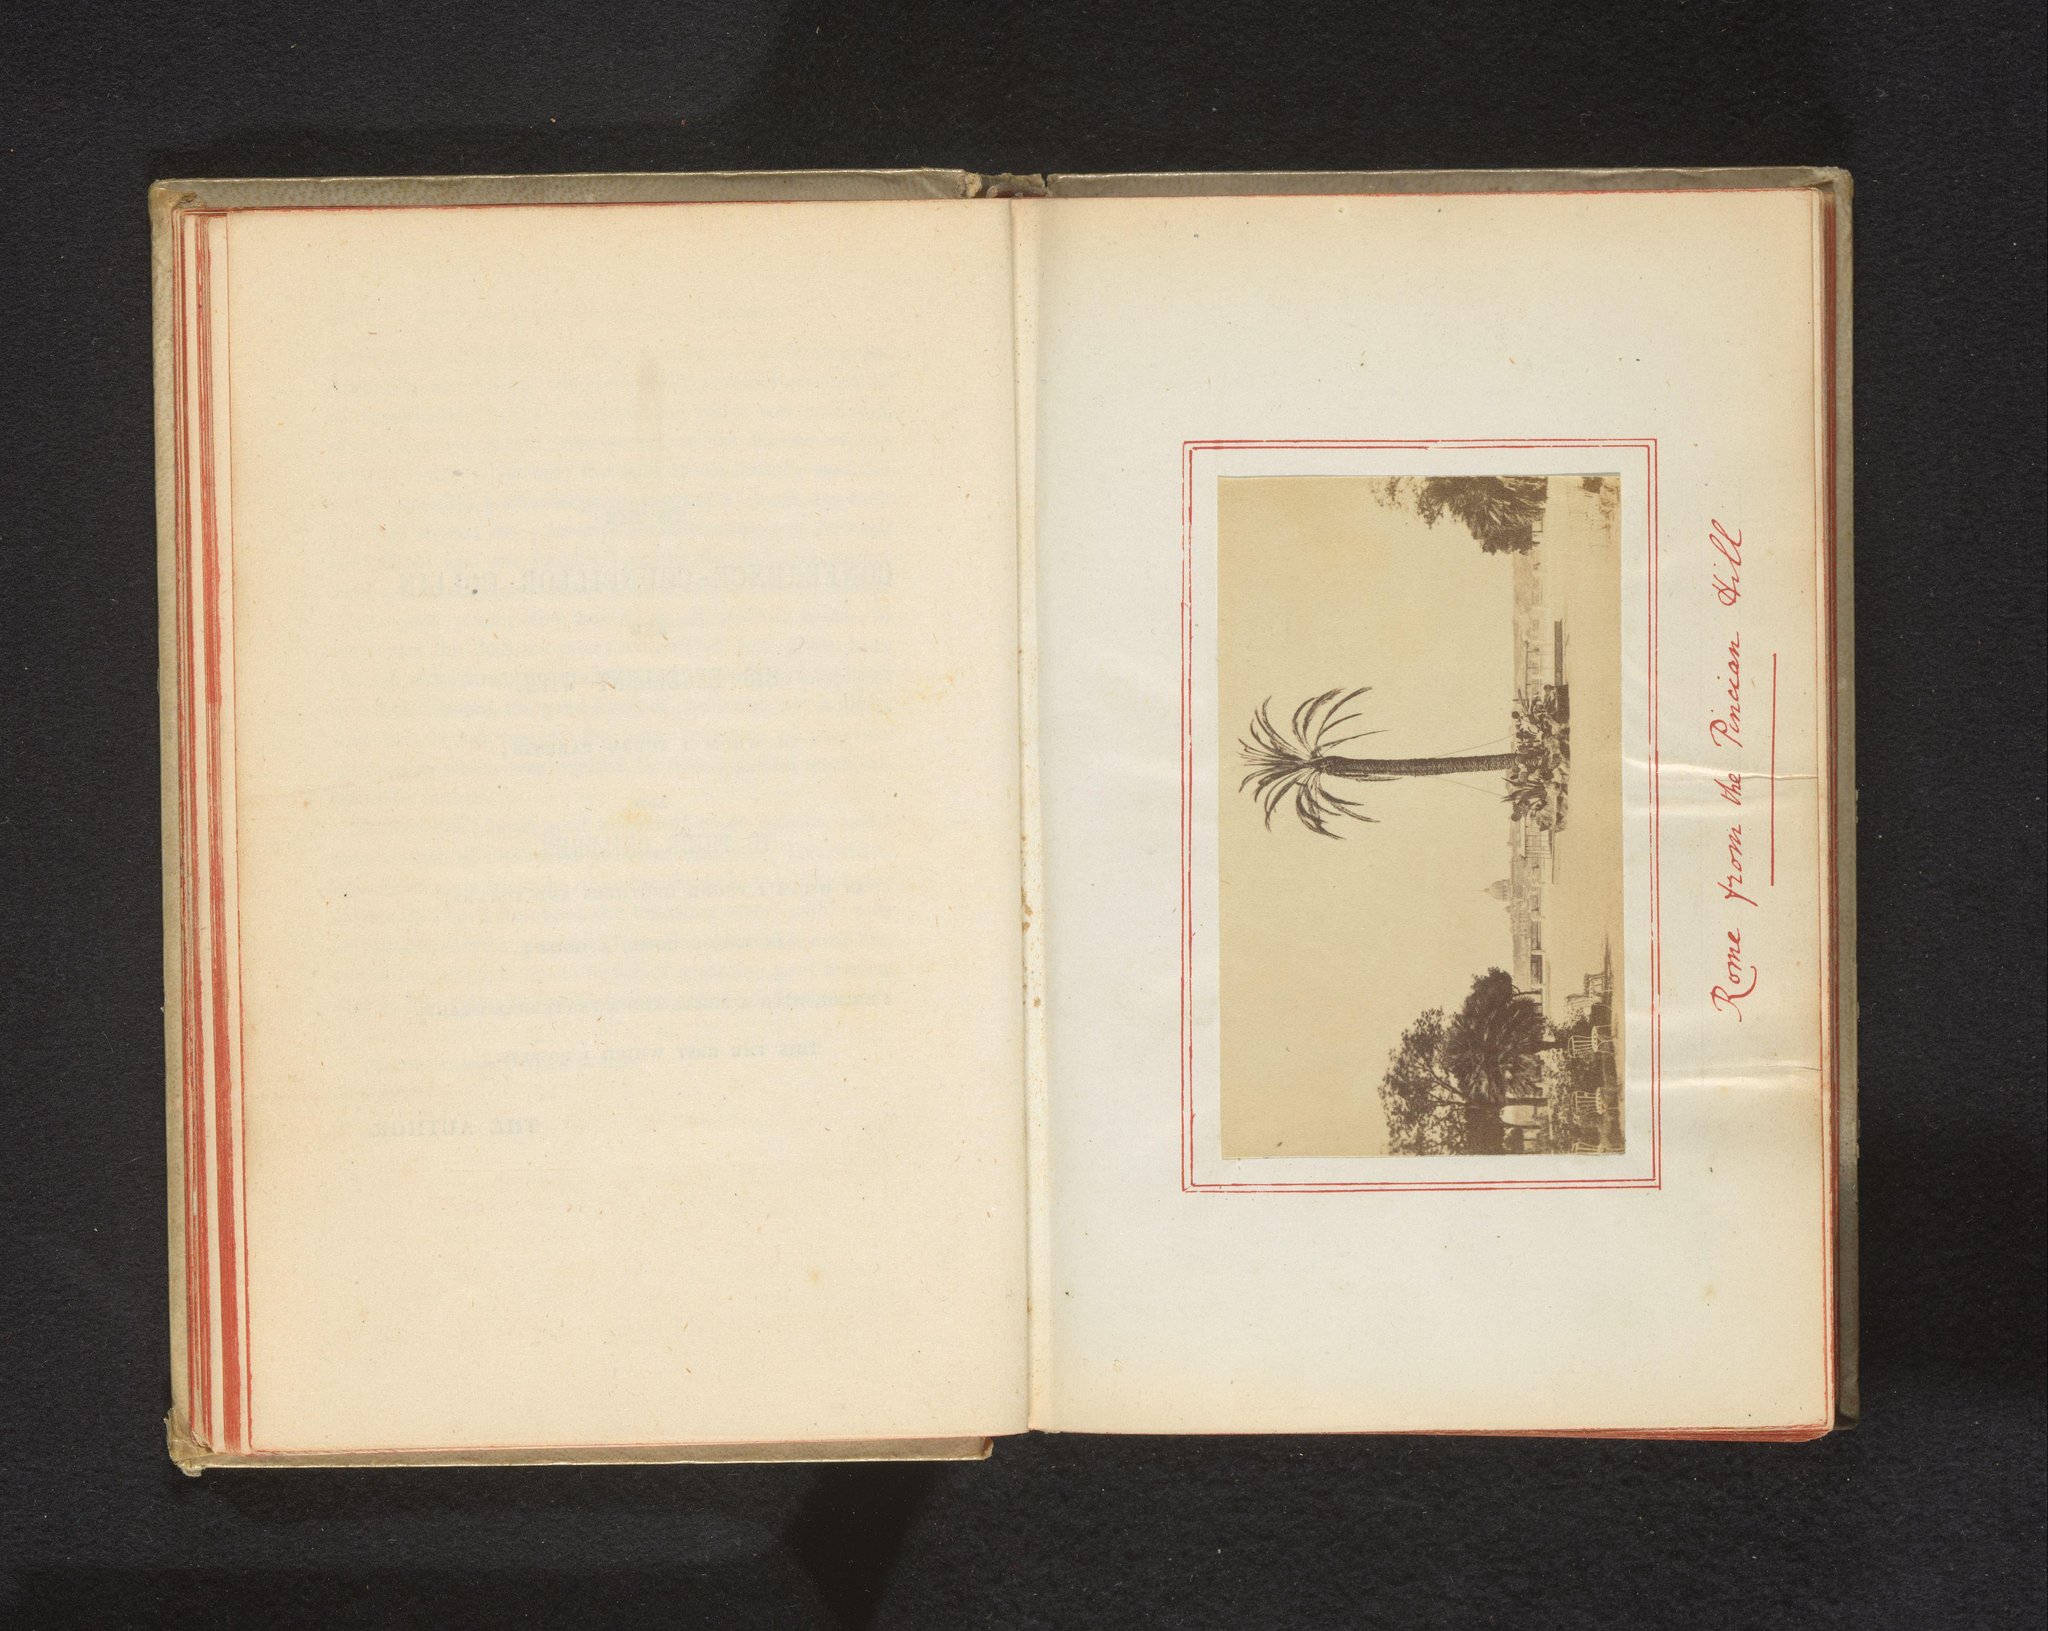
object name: photograph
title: Rome from the Pincian Hill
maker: Anonymous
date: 1863-1873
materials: photographic support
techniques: albumen print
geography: pincio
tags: city-view in general; 'veduta', rome